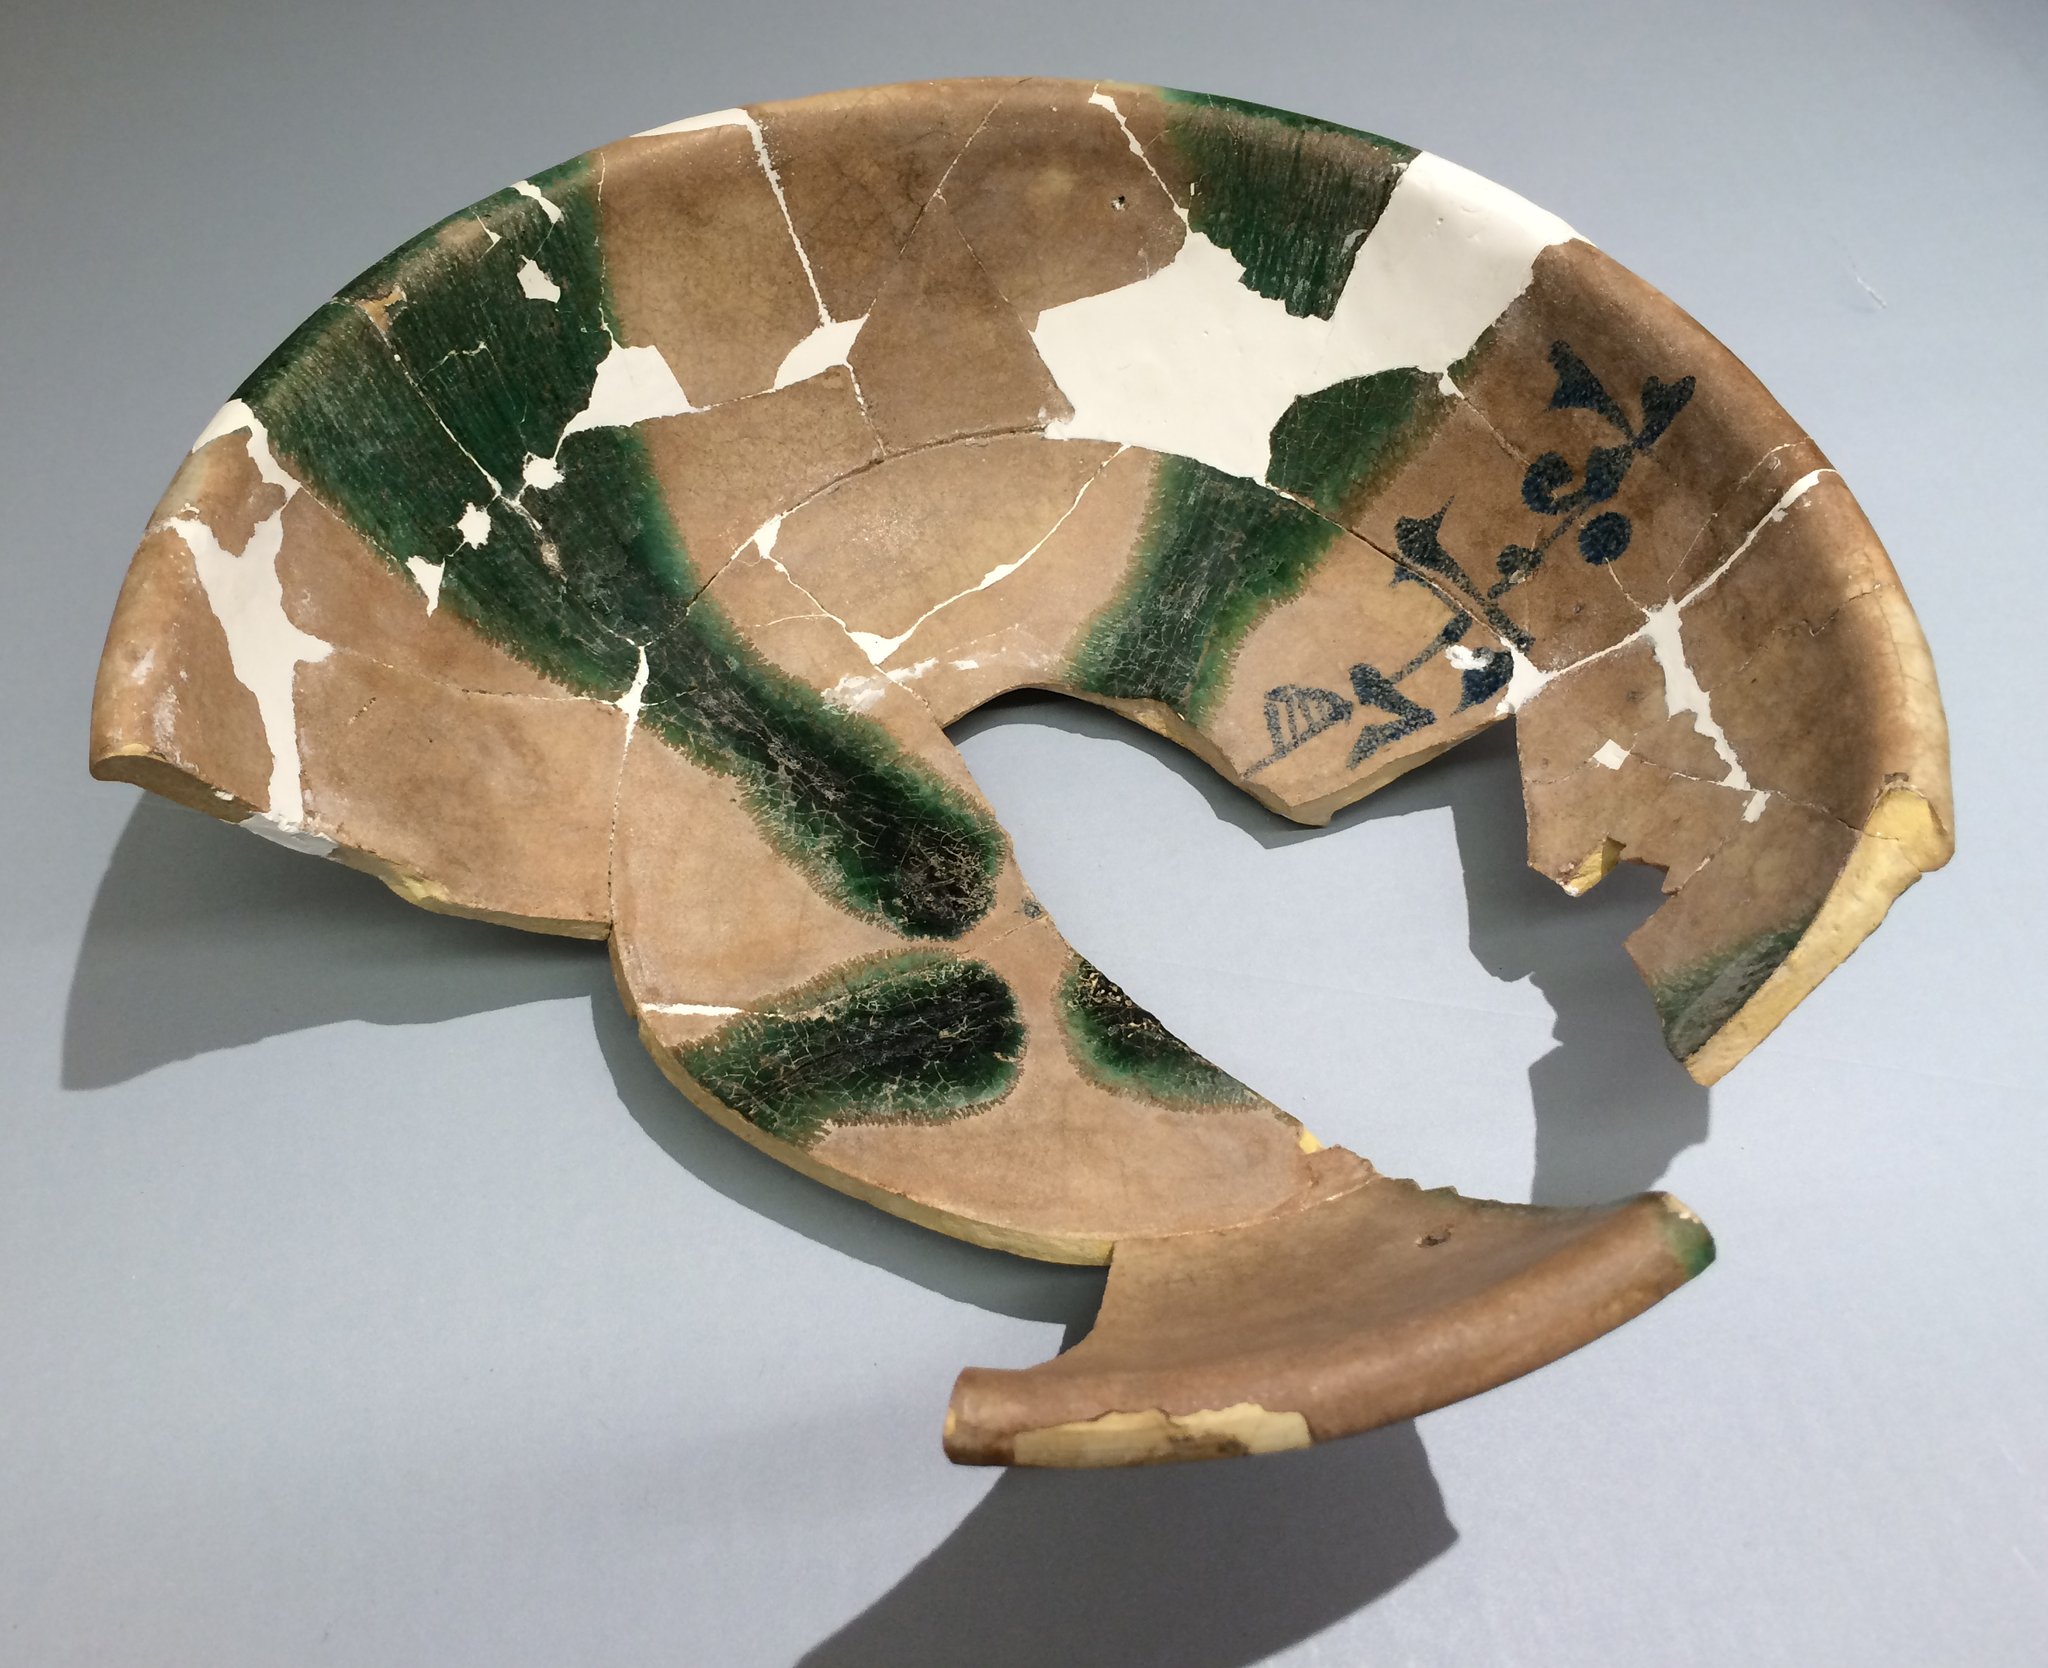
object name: bowl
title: Fragments of a Bowl with Green Splashes and Blue Inscription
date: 801-900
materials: earthenware, glaze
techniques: painting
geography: iraq